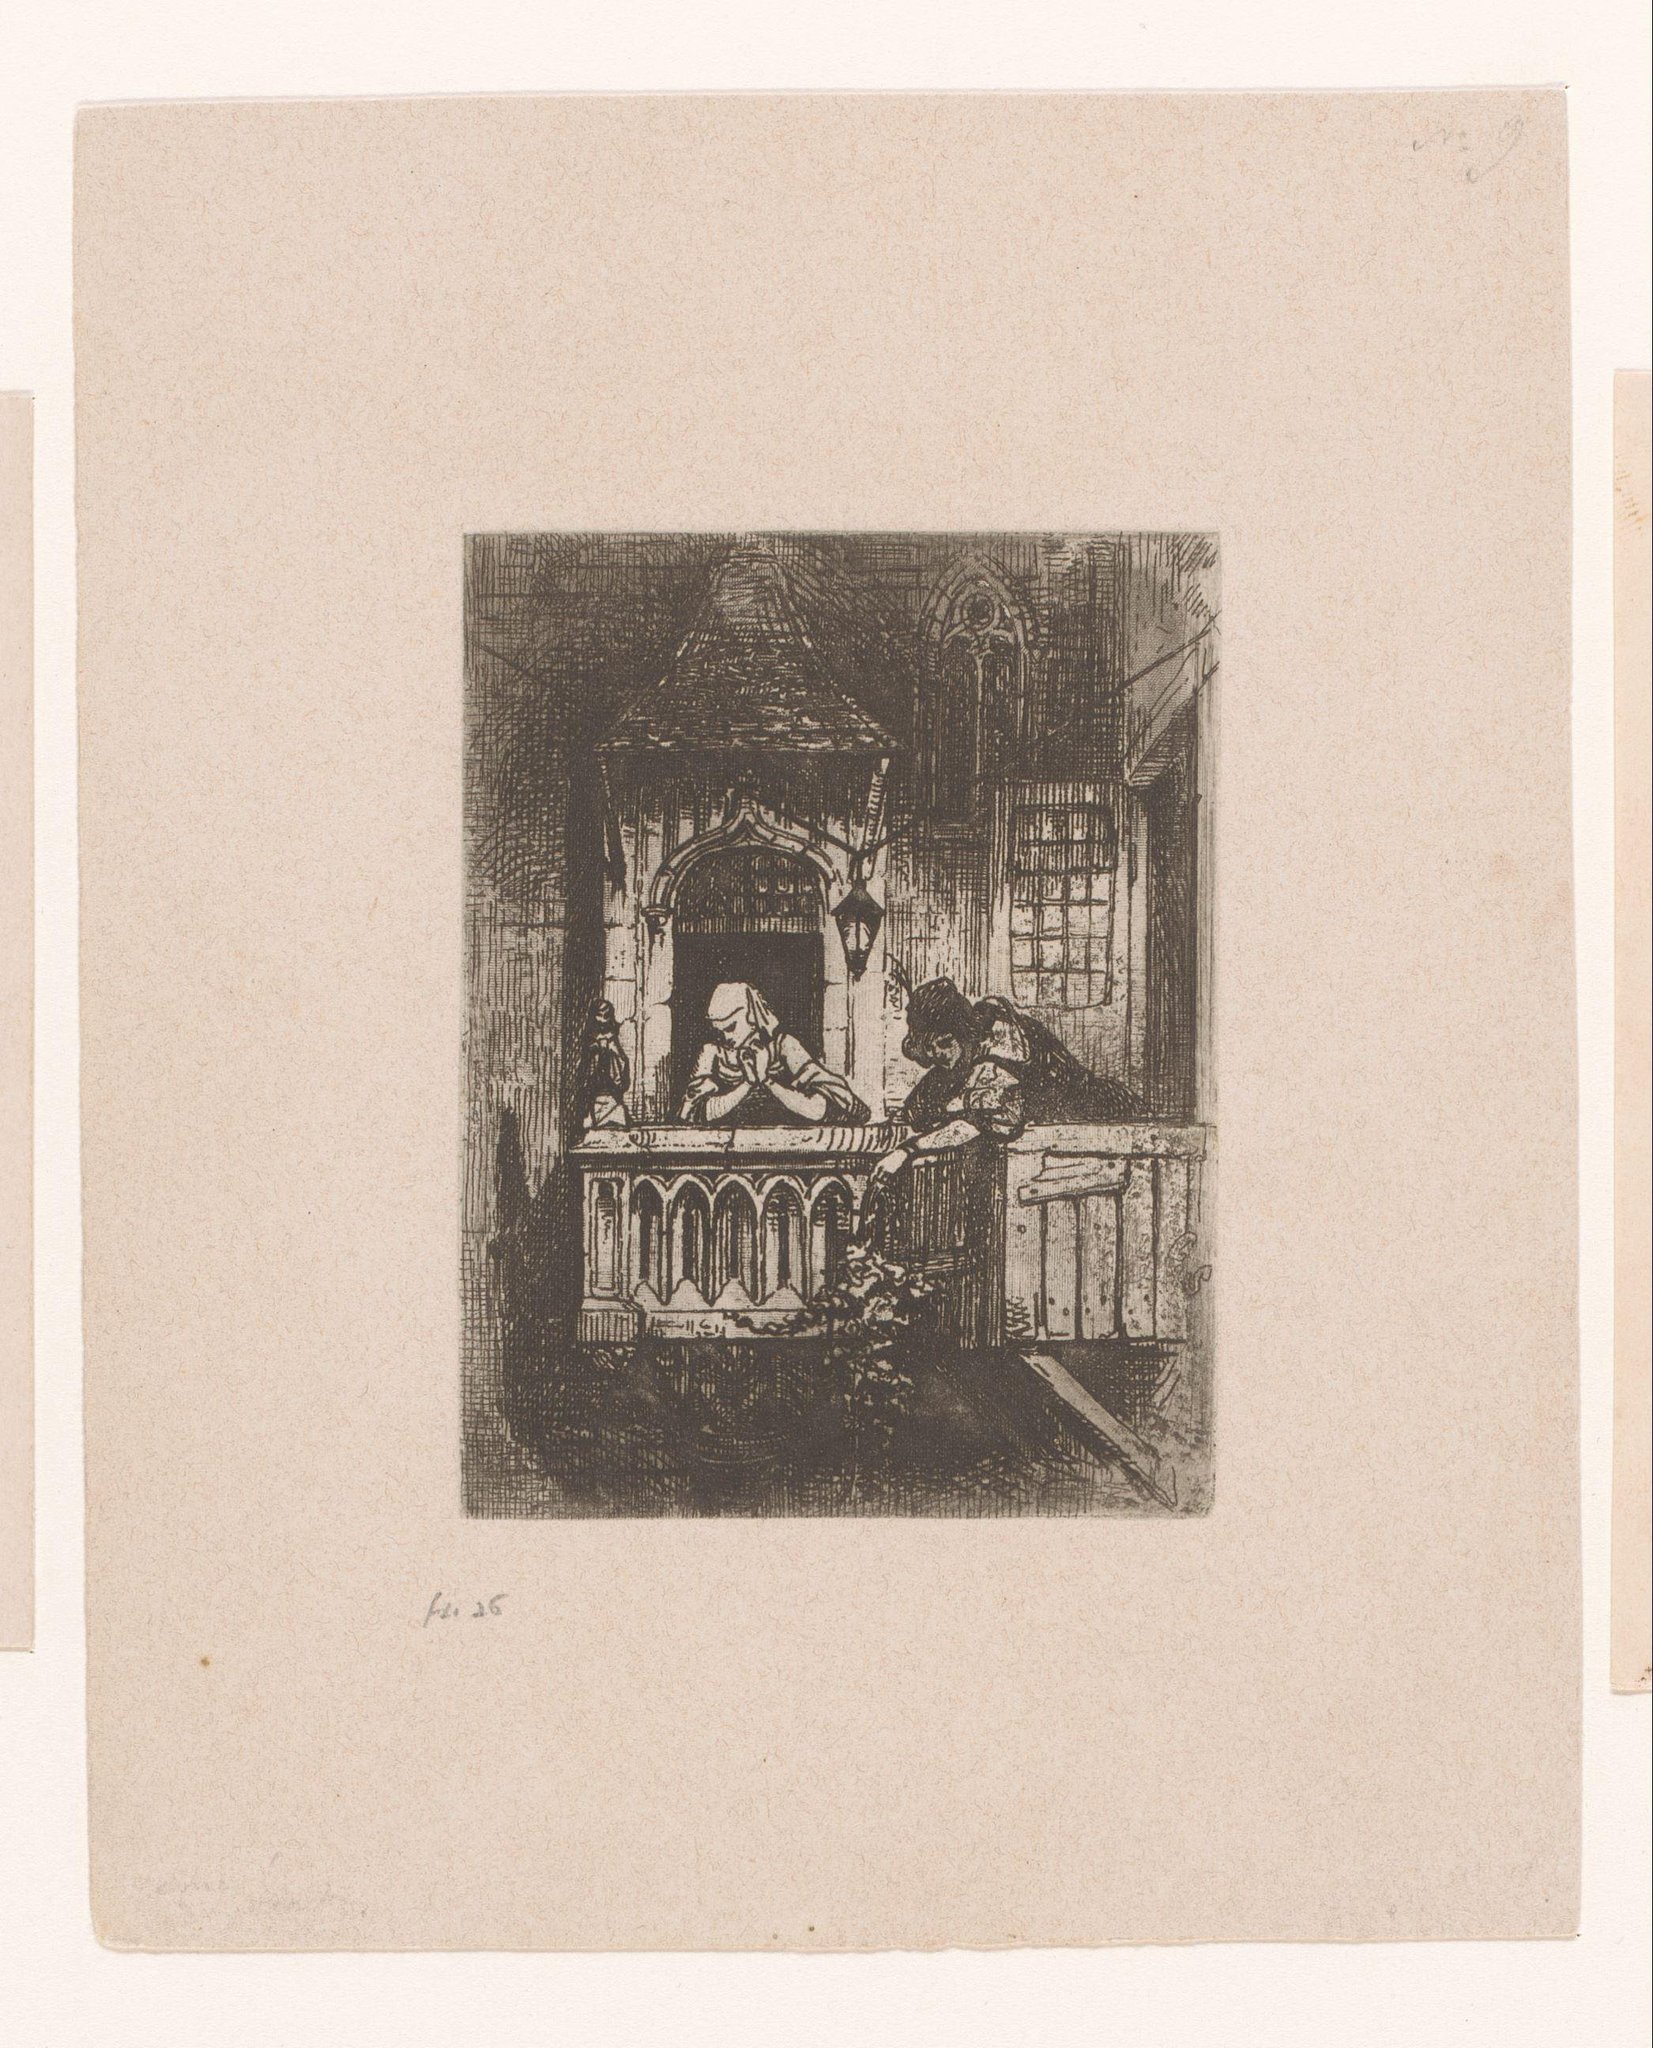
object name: print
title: Man en vrouw leunen over de rand van een balkon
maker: corneille seghers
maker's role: draughtsman, print maker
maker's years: 1814-1869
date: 1824-1869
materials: paper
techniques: drypoint, etching, intaglio, roulette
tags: leaning forward, balcony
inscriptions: collector's mark: Lugt 2228